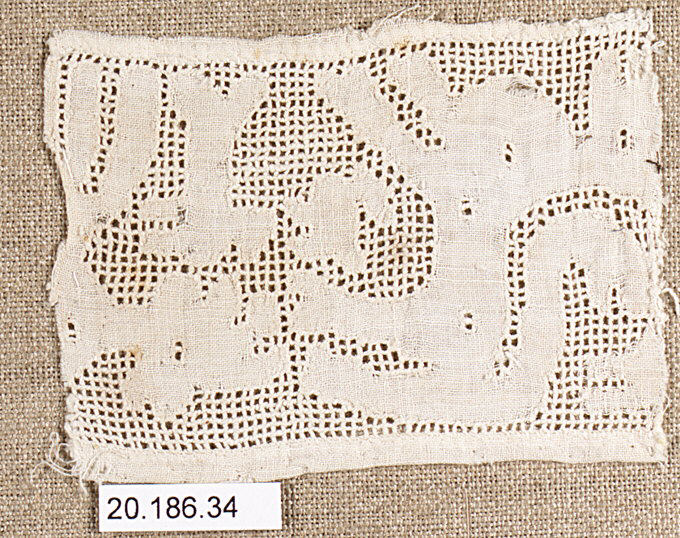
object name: fragment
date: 1501-1600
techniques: embroidery